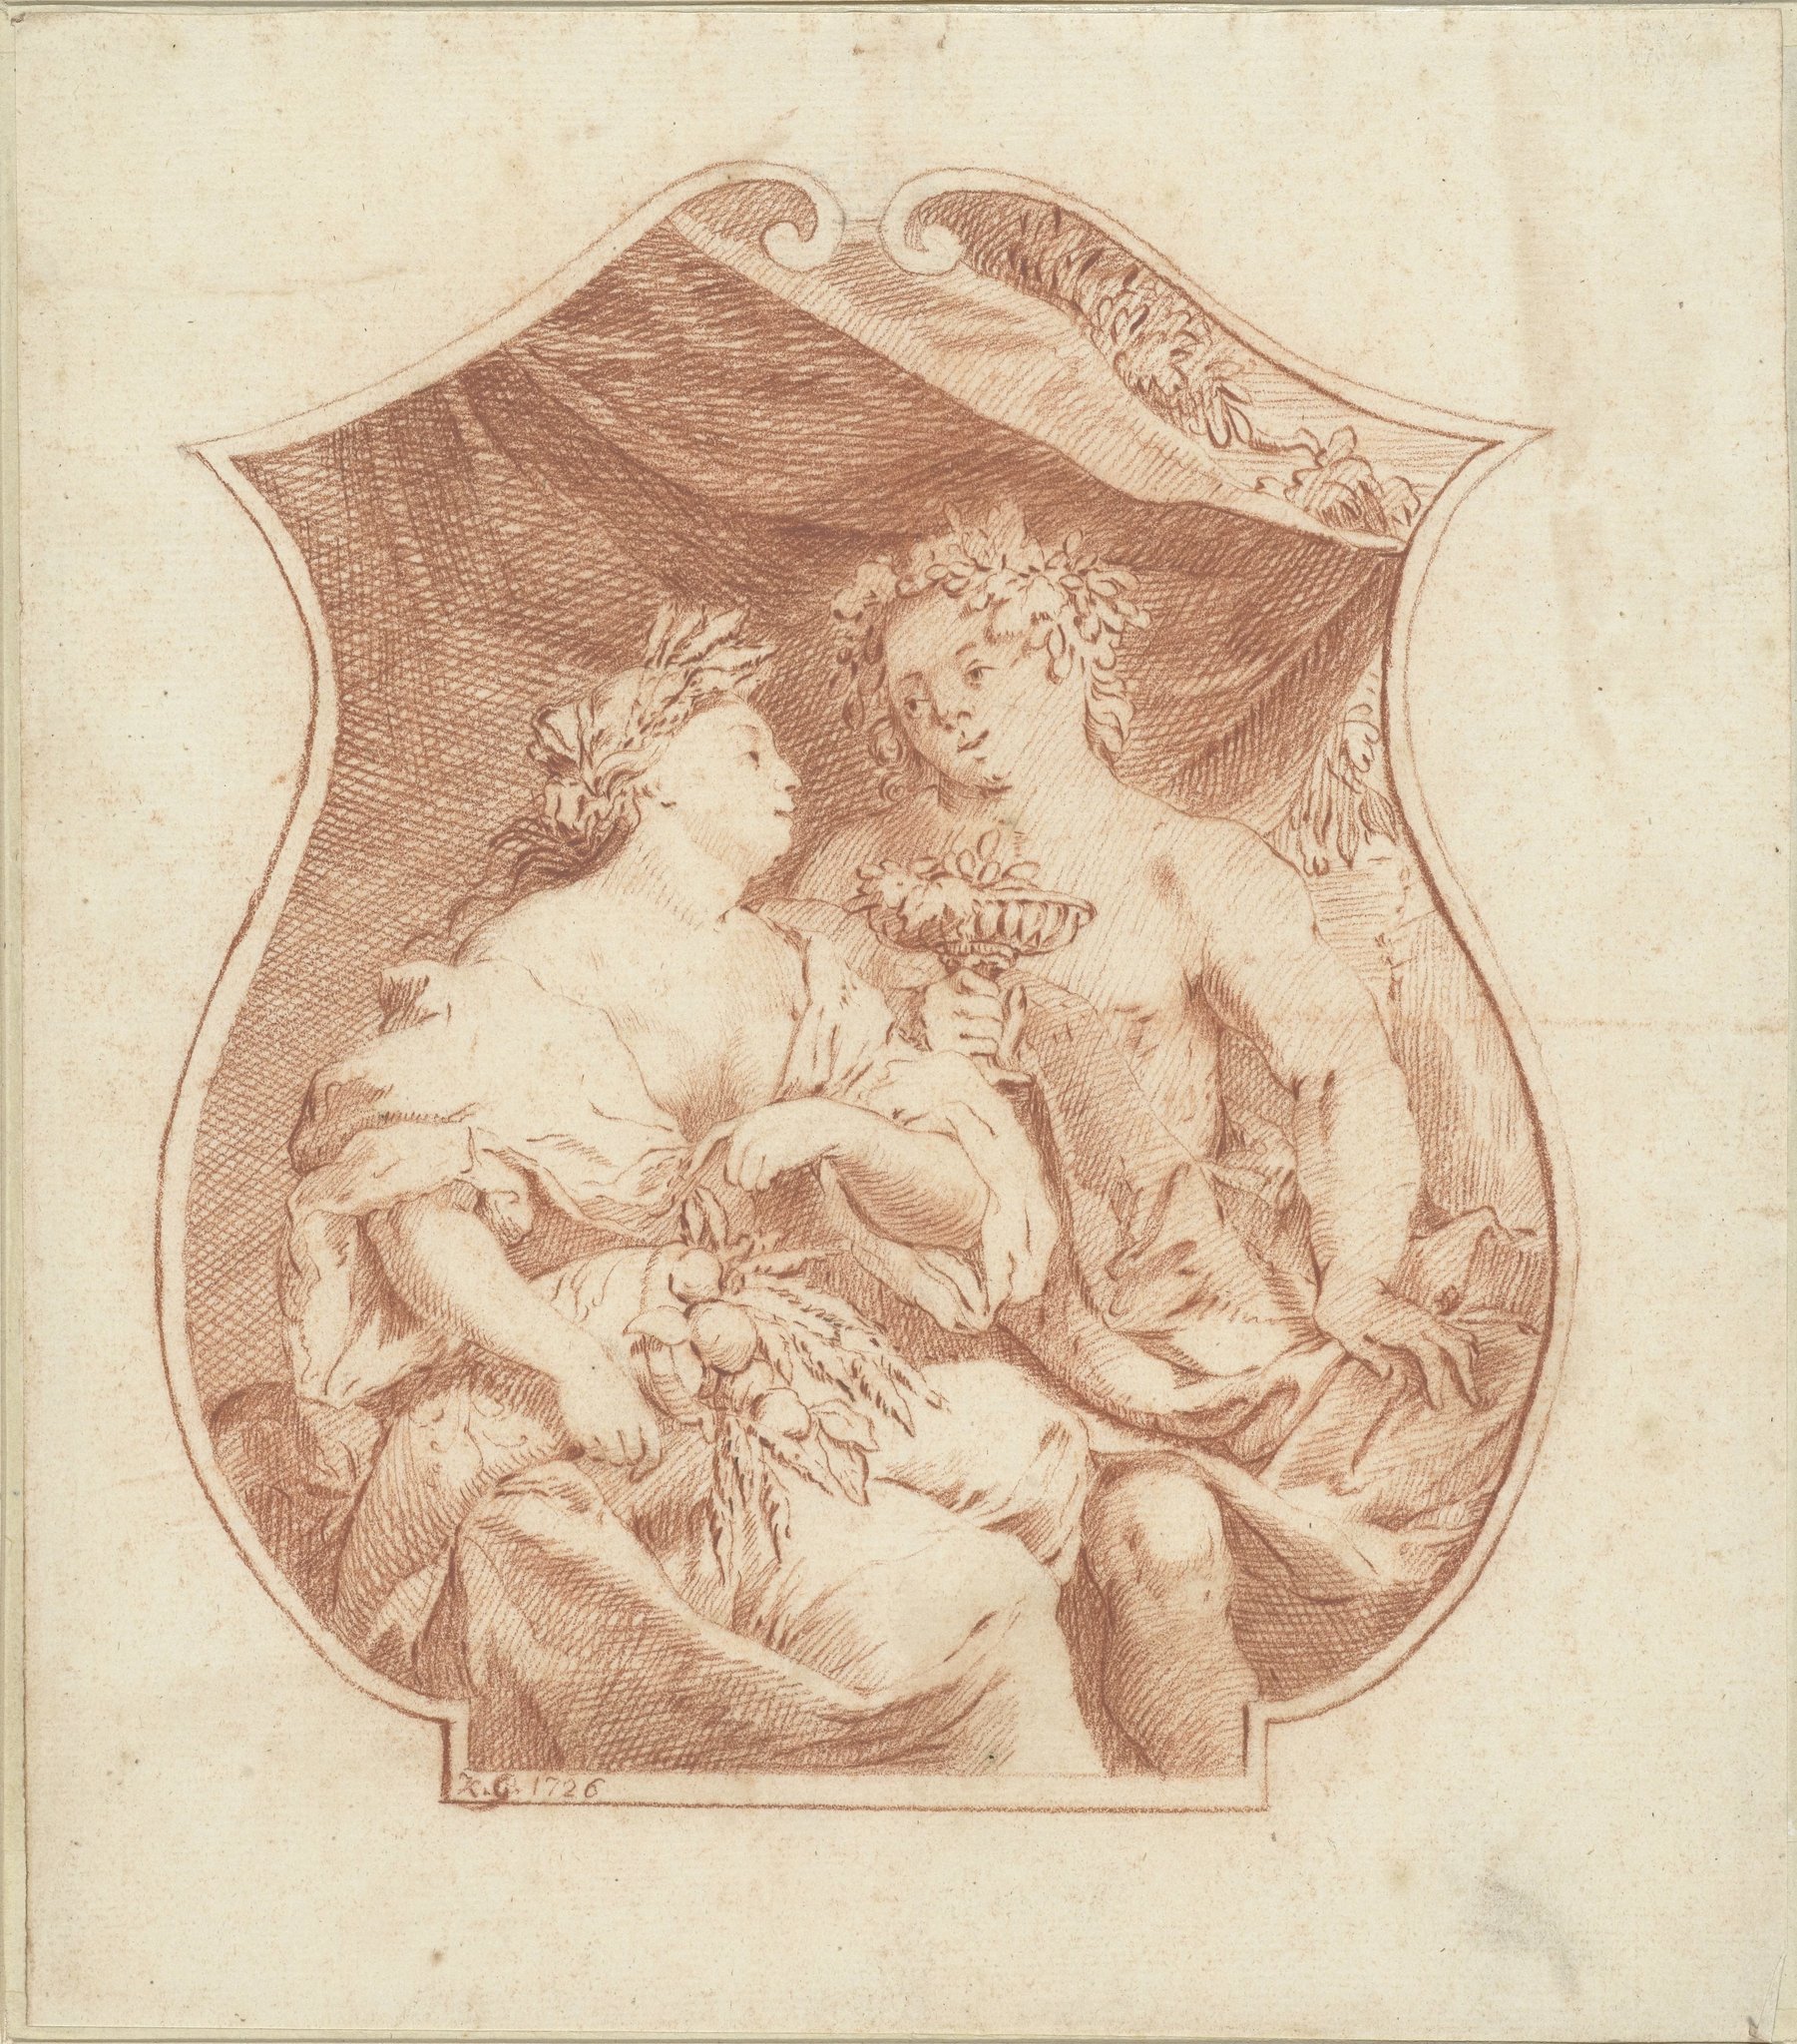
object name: drawing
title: Bacchus en Ceres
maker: monogrammist kg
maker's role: draughtsman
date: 1726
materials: chalk, paper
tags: (story of) ceres (demeter), (story of) bacchus (dionysus), liber